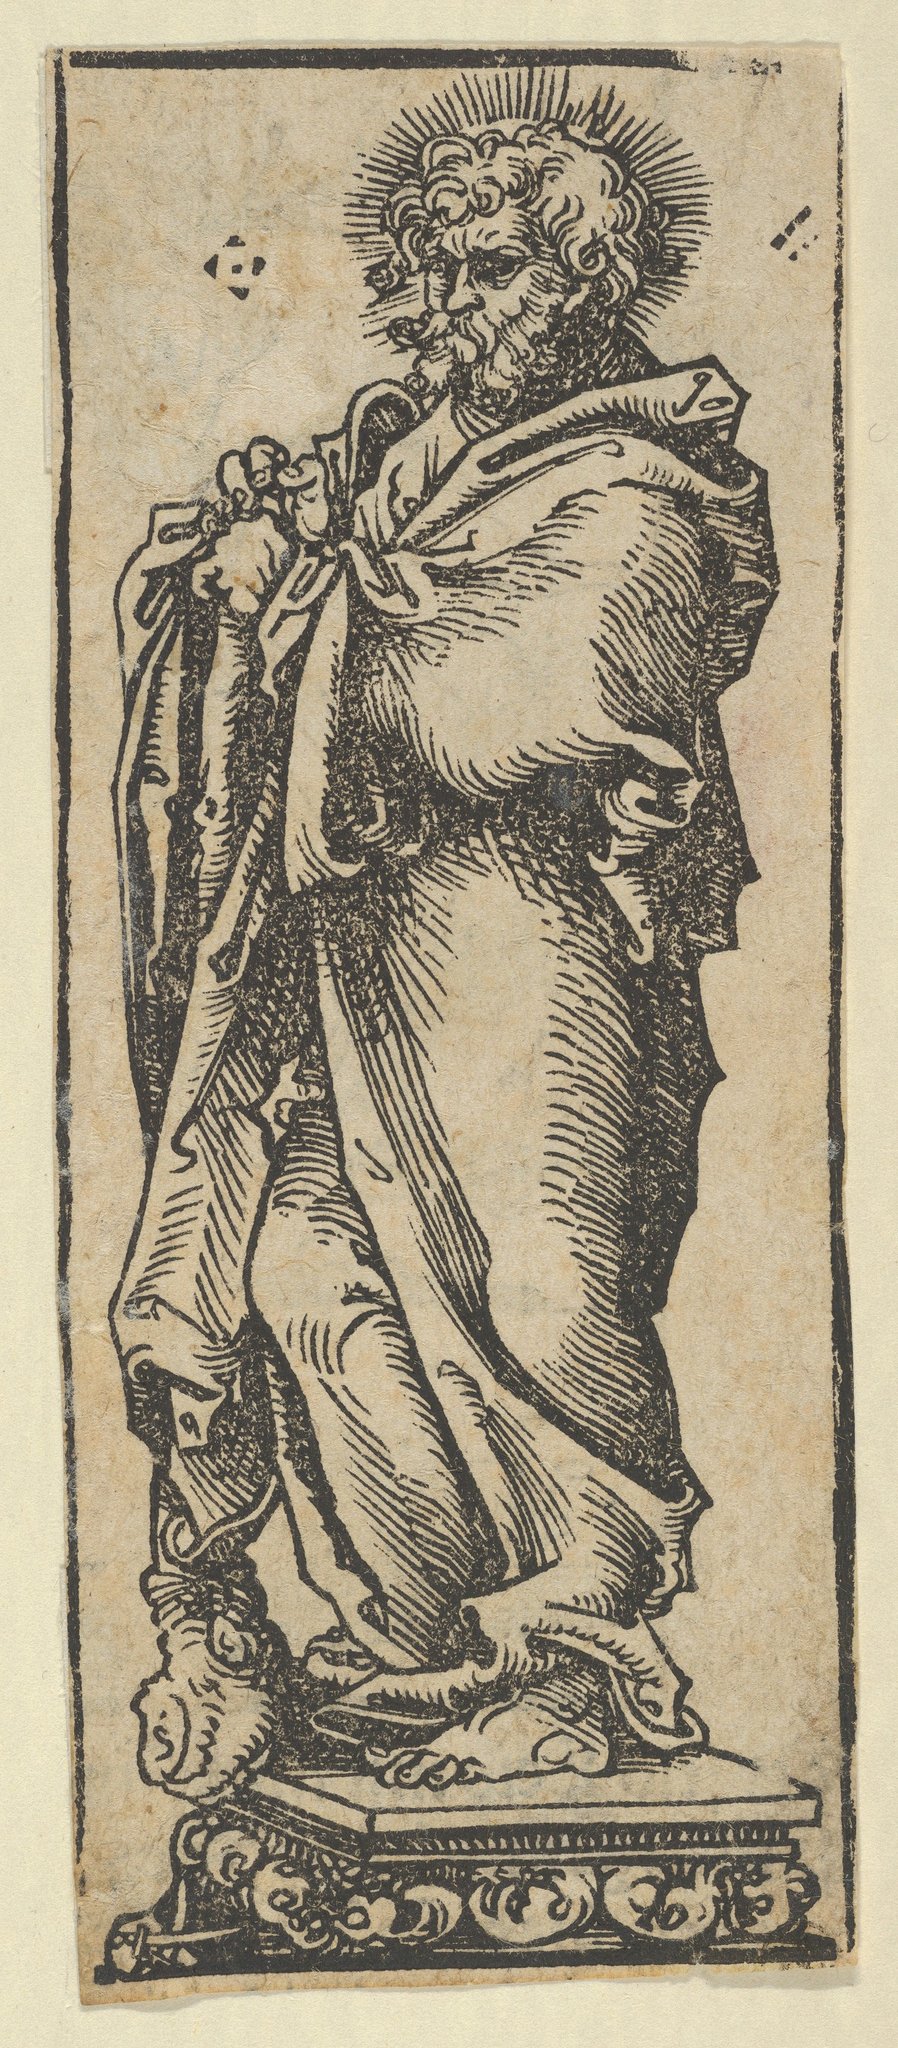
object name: print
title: Silver Statuette of St. Jude, from the "Wittenberg Reliquaries"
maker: lucas cranach the elder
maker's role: artist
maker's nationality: german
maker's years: 1472-1553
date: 1472-1553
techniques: woodcut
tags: saints